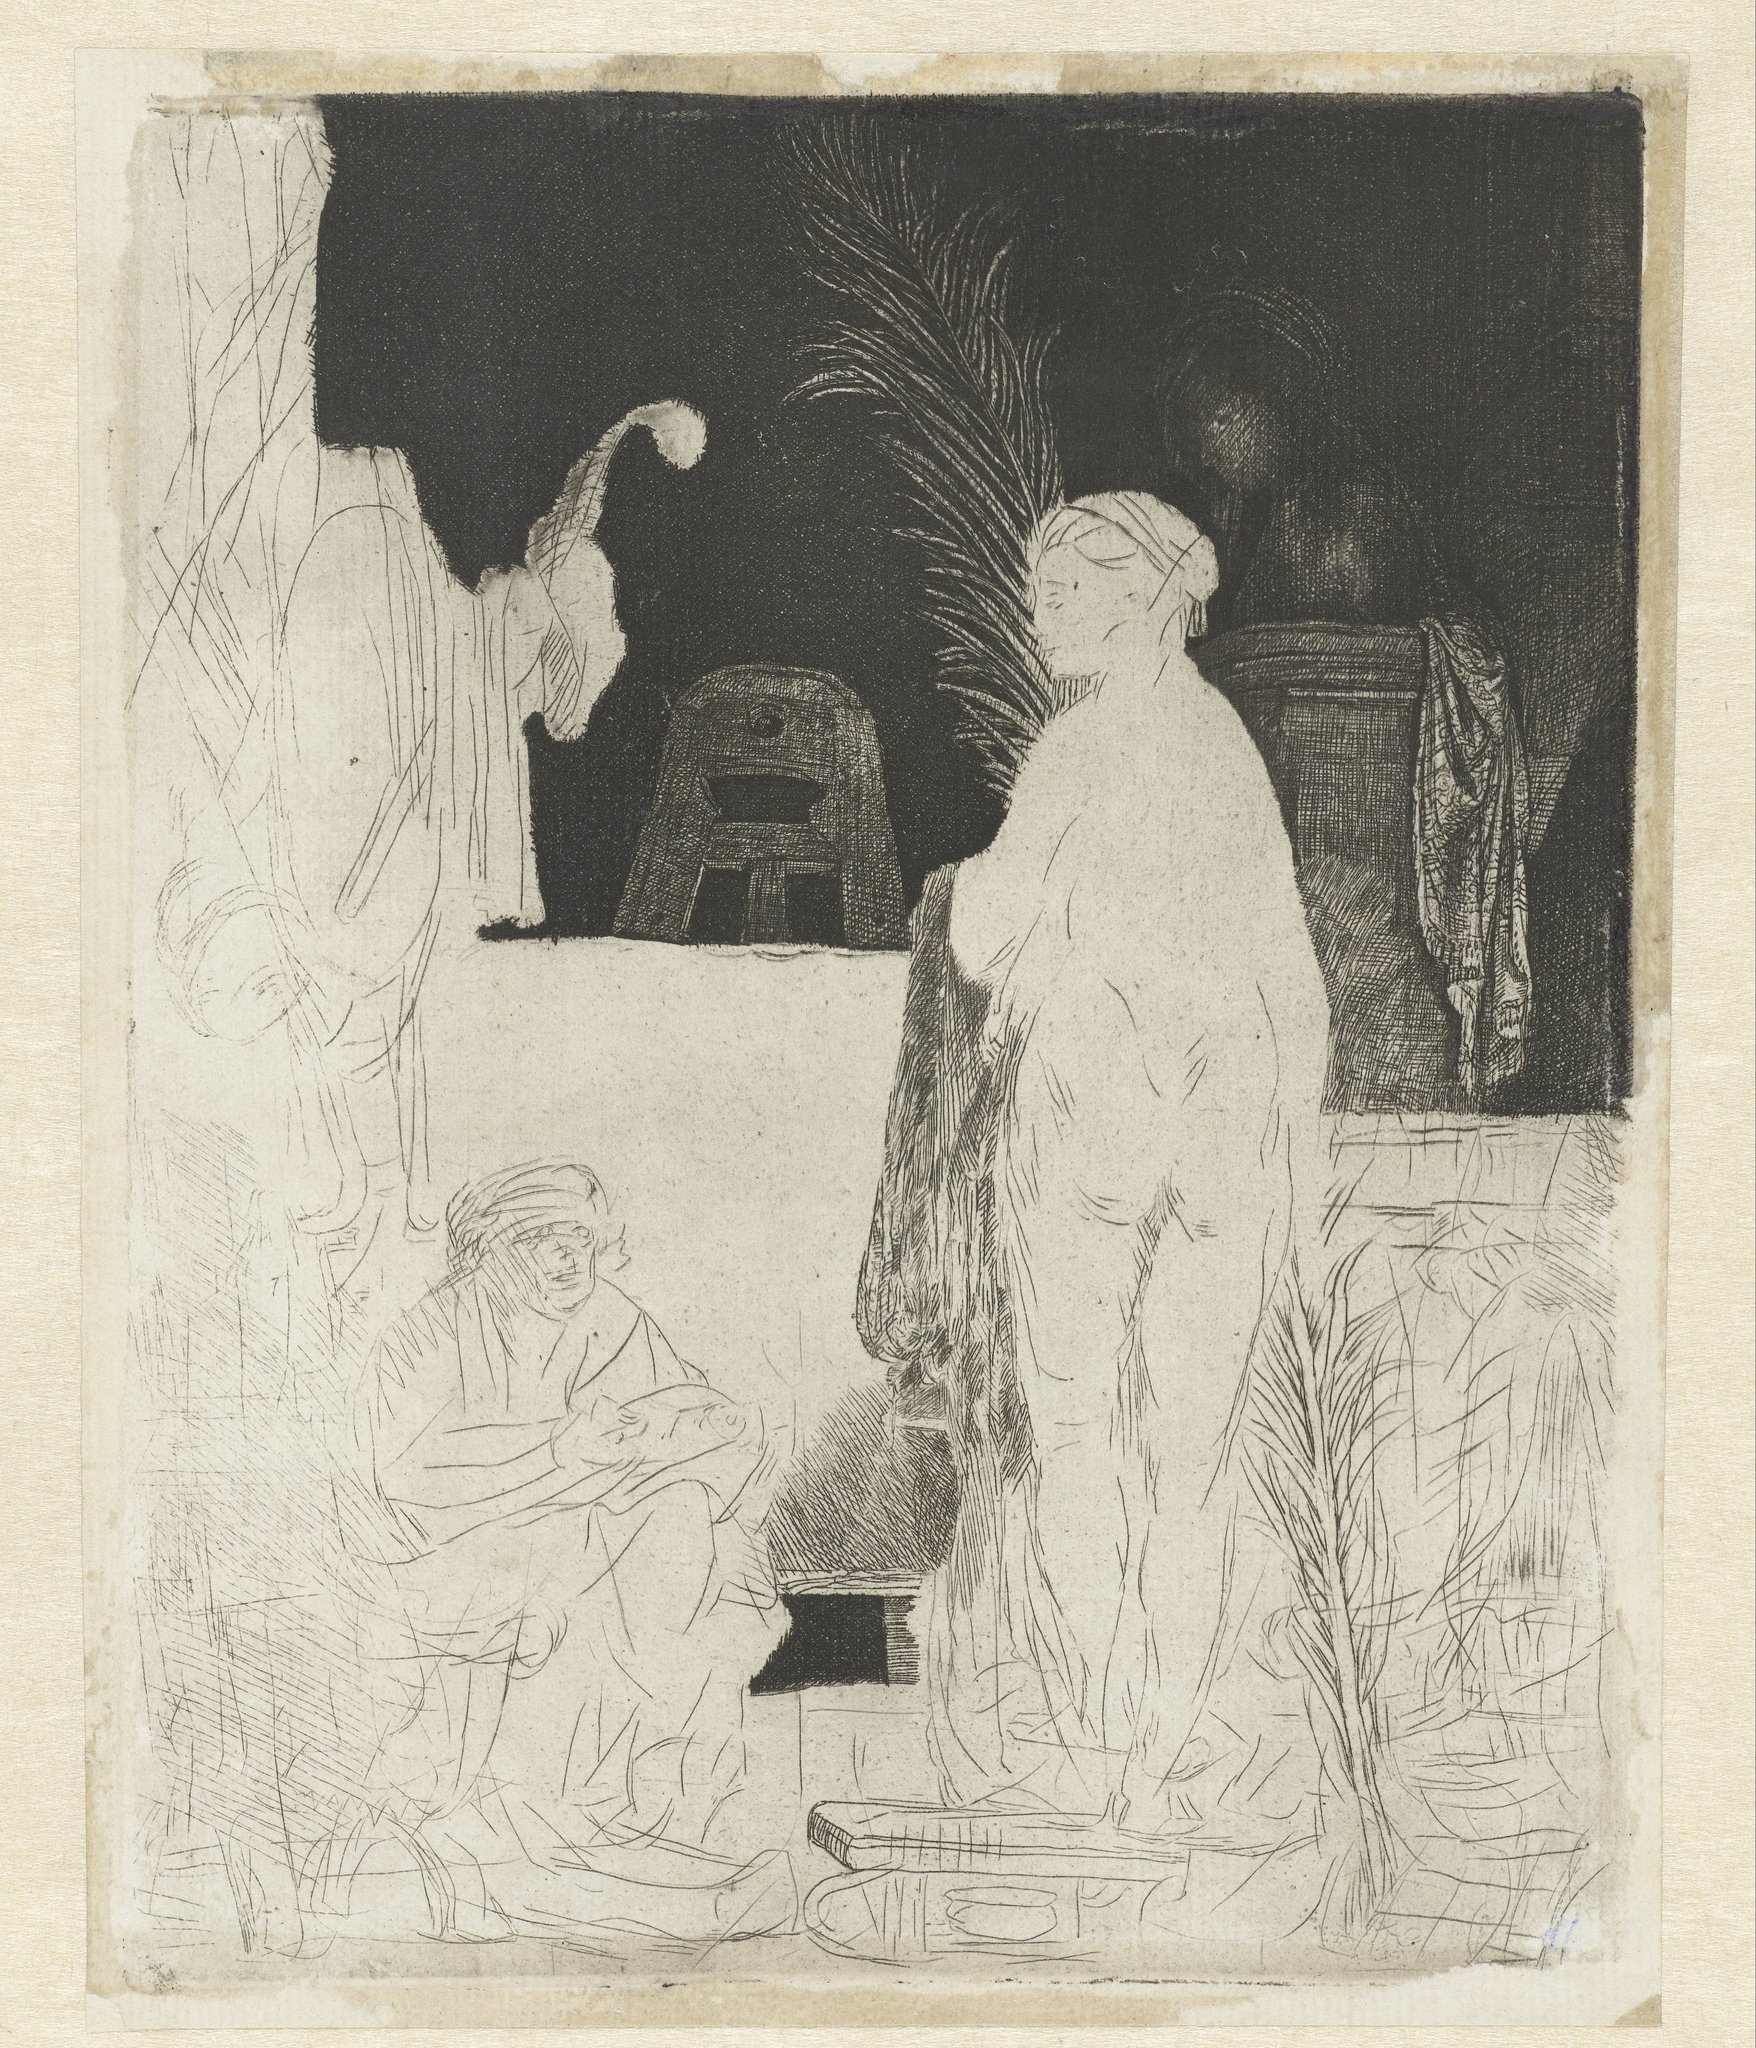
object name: print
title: The artist drawing from the model ('Het beeldt van Pigmalion')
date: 1750-1778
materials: paper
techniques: etching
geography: augsburg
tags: artist (in general) working from live model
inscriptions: collector's mark: Lugt 2228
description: Mogelijk is de kunstenaar Rembrandt zelf.